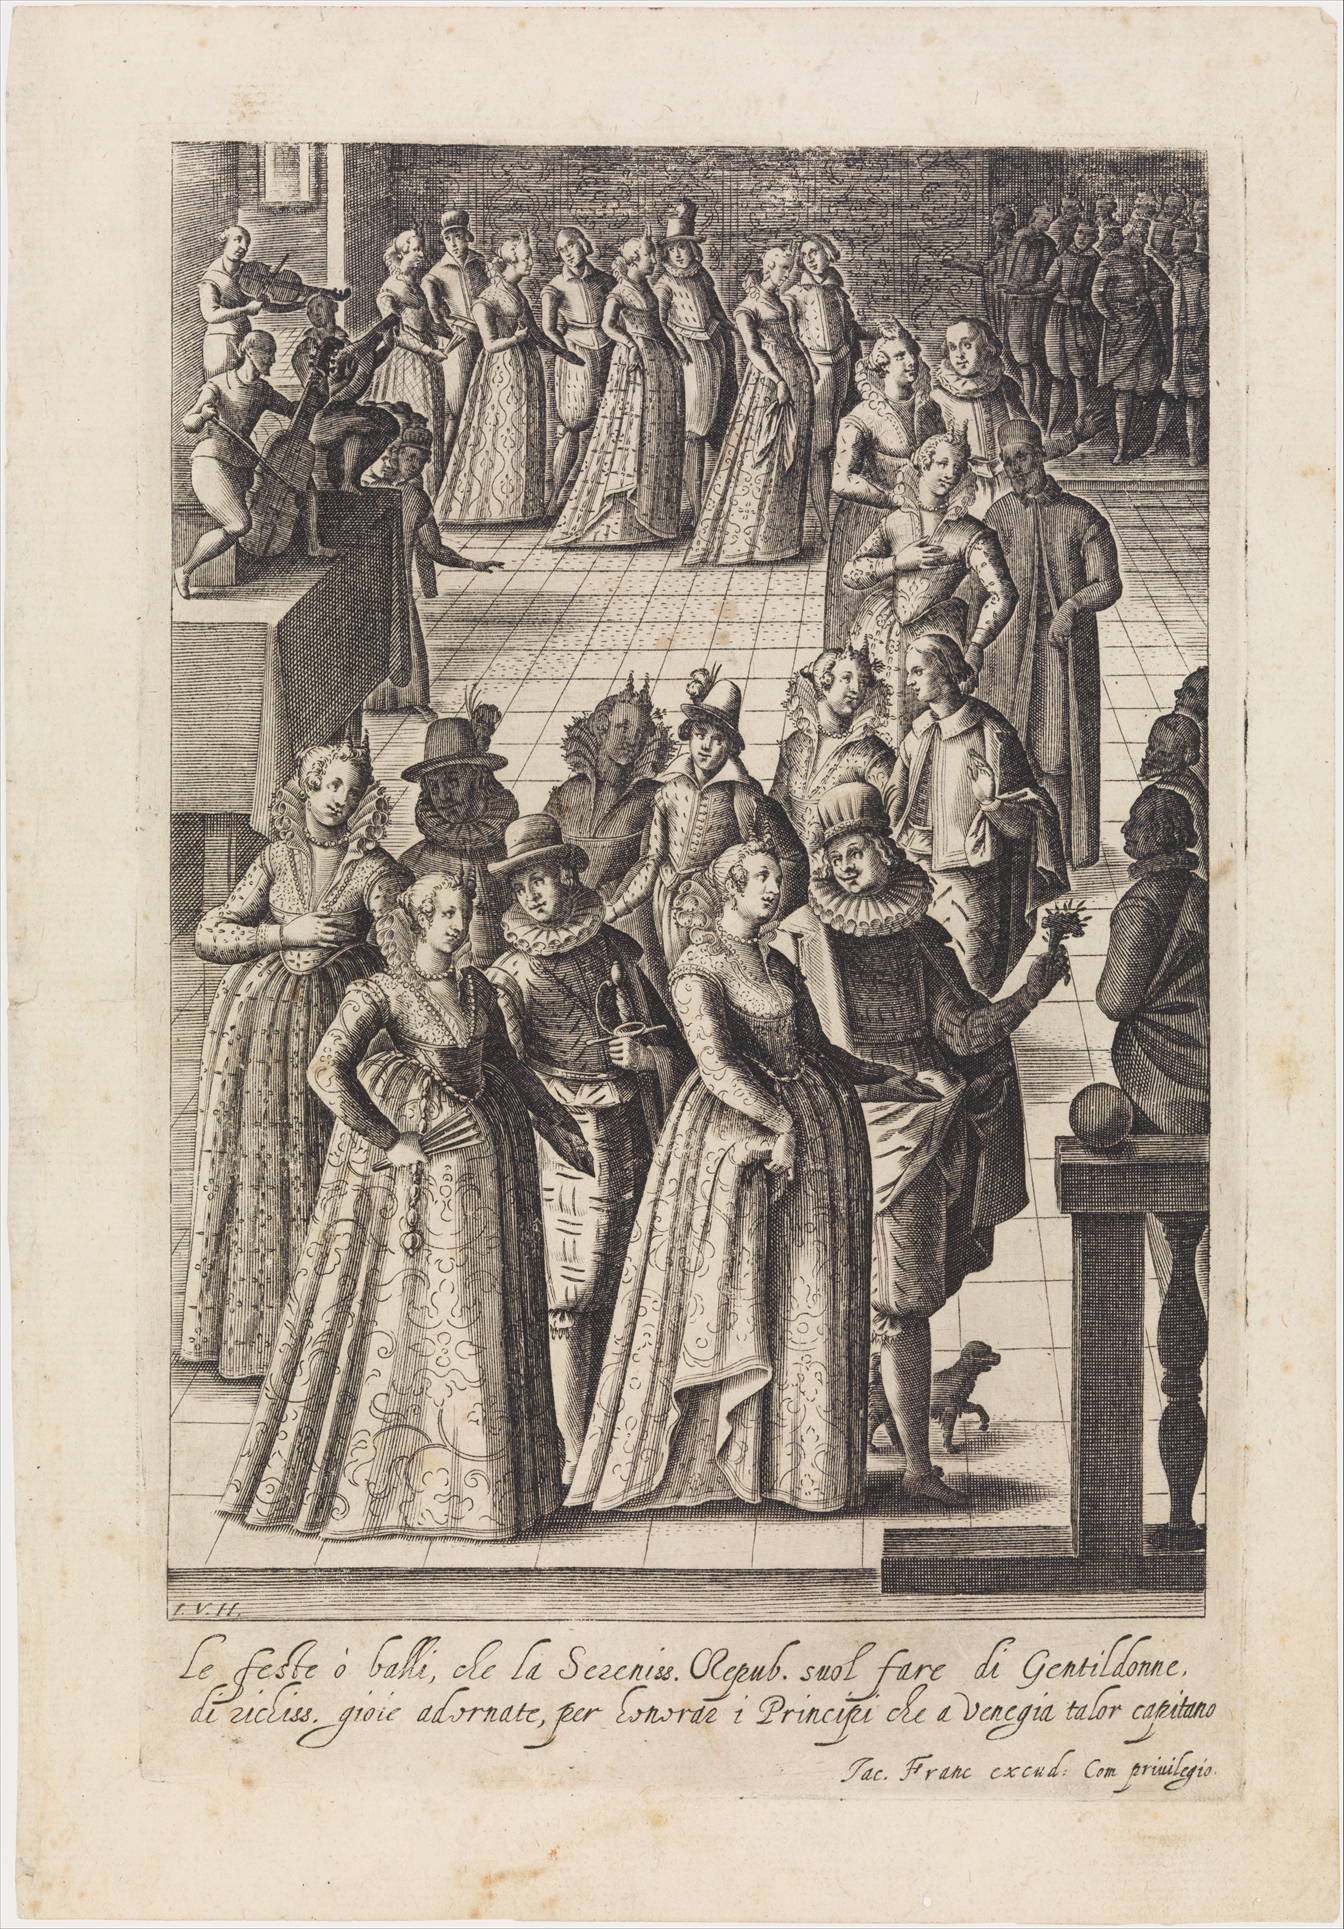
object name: print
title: Le feste o balli from Habiti d'huomeni et donne Venetiane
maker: giacomo franco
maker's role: artist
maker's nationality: italian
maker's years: 1550-1620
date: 1610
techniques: engraving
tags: men,women,dancing